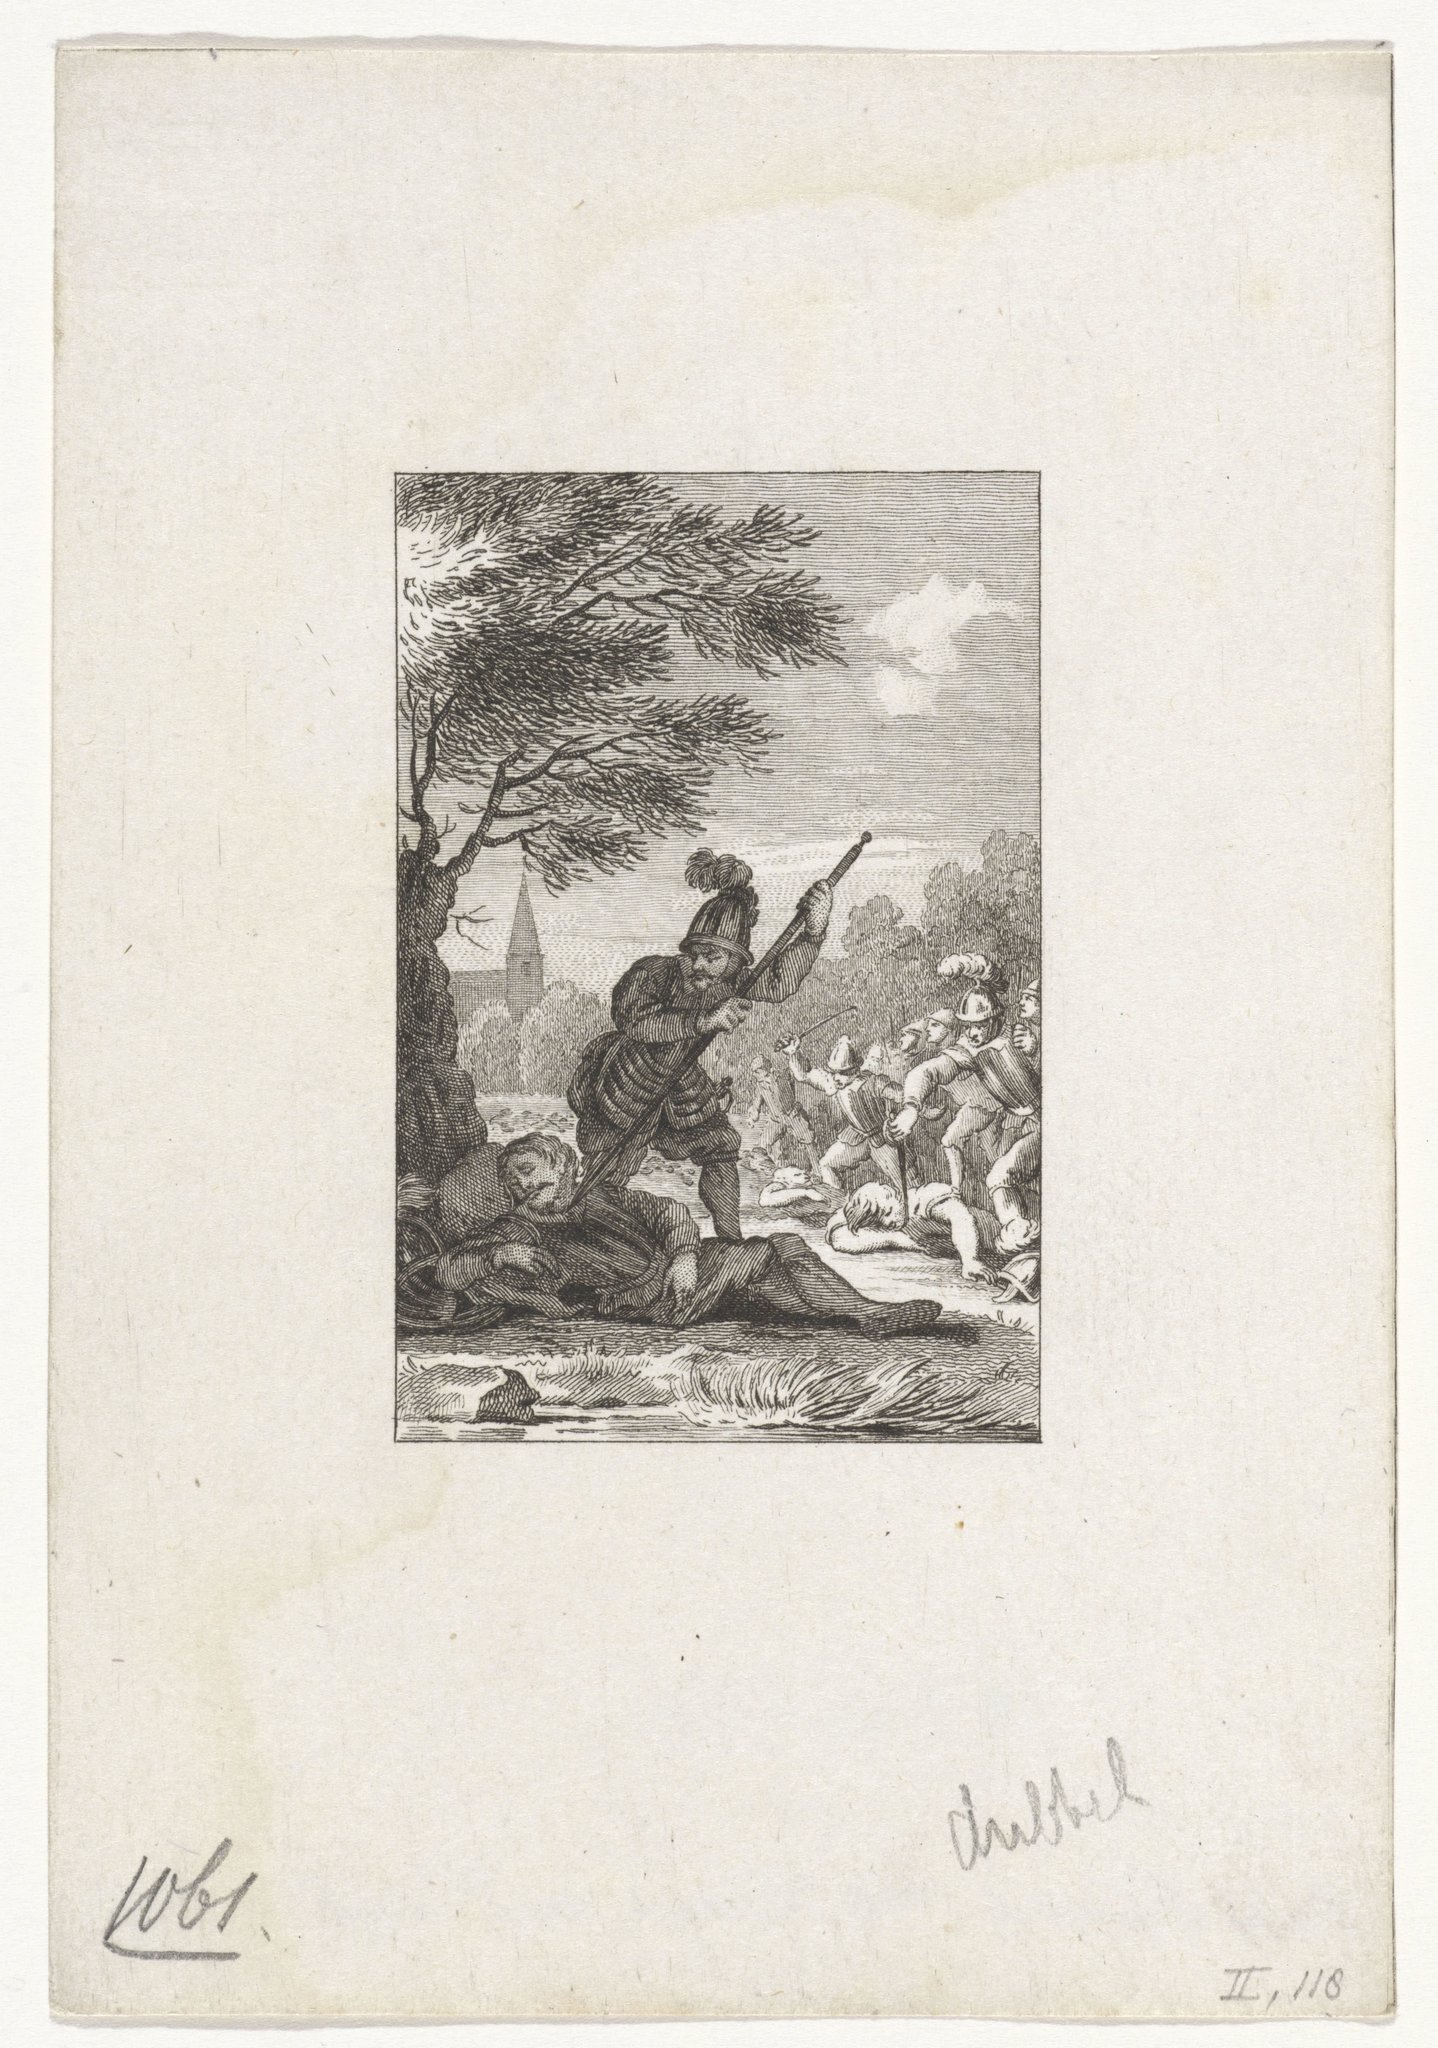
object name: print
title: Moord op Floris I, 1061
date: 1783-1795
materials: paper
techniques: etching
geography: amsterdam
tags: violent death, being killed; being mishandled and maltreated; seeking death, attempt, political murder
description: Illustratie voor: J. Fokke. Geschiedenissen der Vereenigde Nederlanden voor de vaderlandsche jeugd. Amsterdam: Johannes Allart, 1783-1795, 25 delen. deel II pl. III.